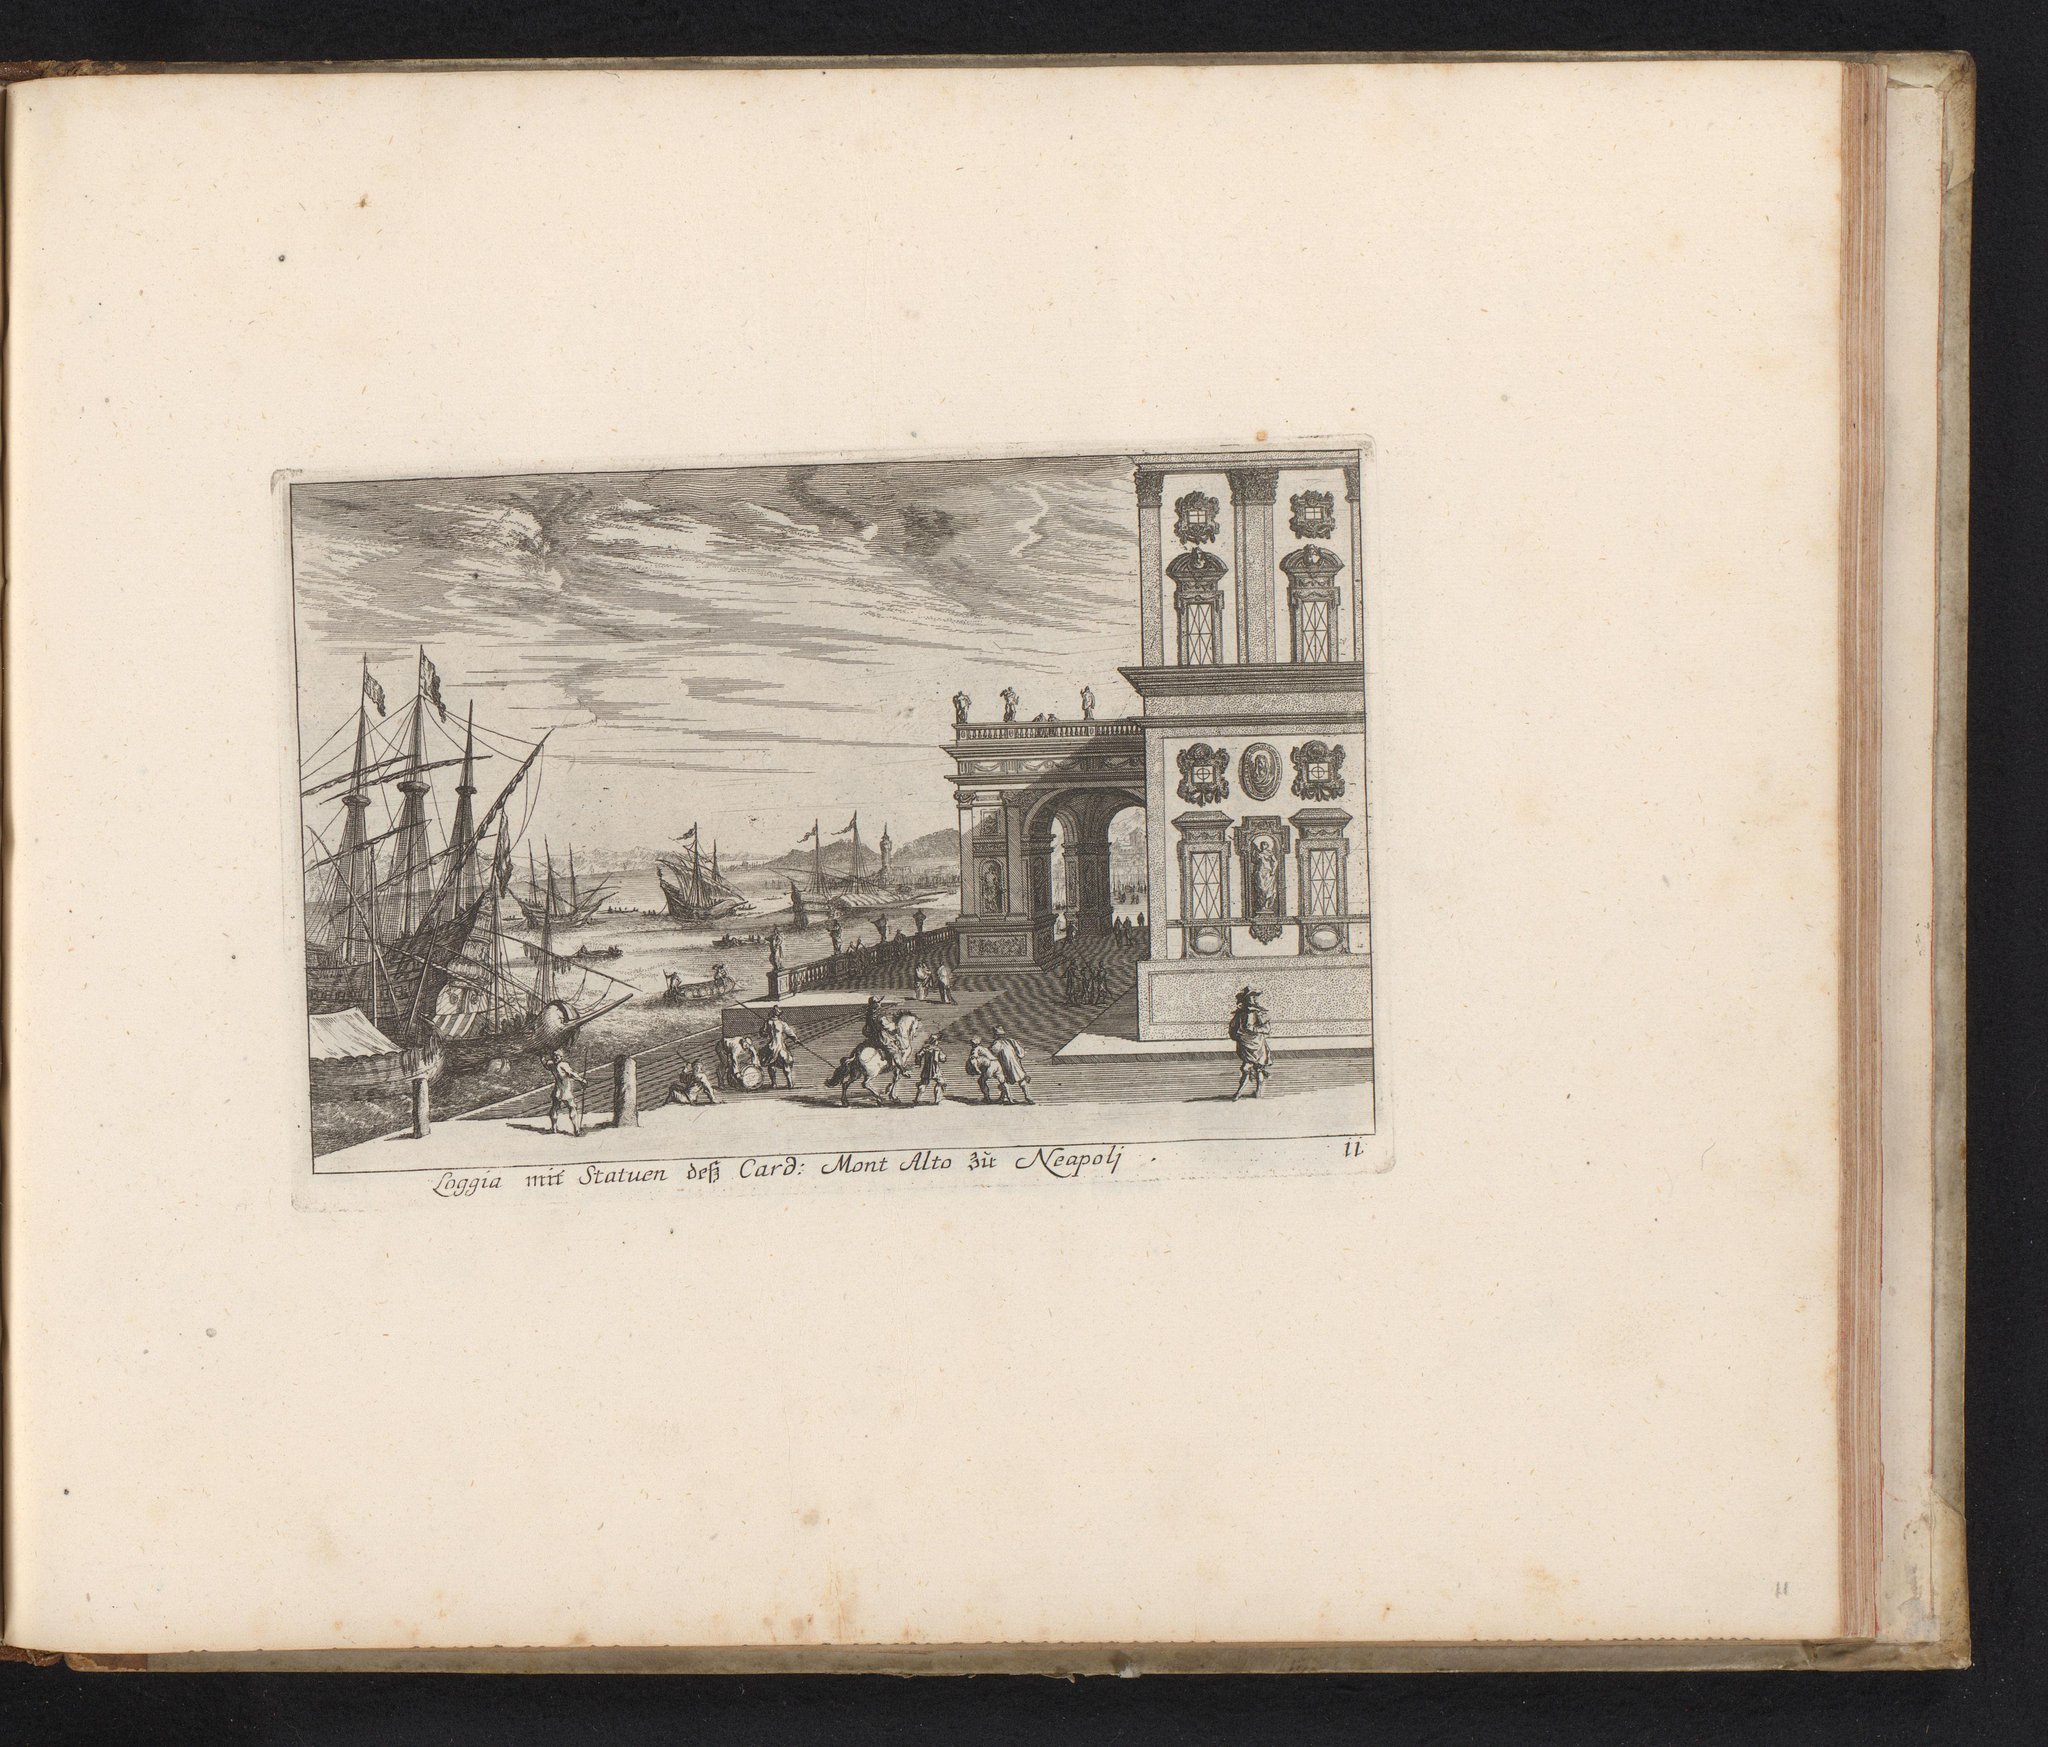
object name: print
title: Gezicht op een loggia bij de haven van Napels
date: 1670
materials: paper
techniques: etching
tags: harbour, loggia, verandah, porch, naples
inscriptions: collector's mark: Lugt 2228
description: Tekst in het Duits in de ondermarge. Rechtsonder genummerd: 11. Prent maakt deel uit van een album.